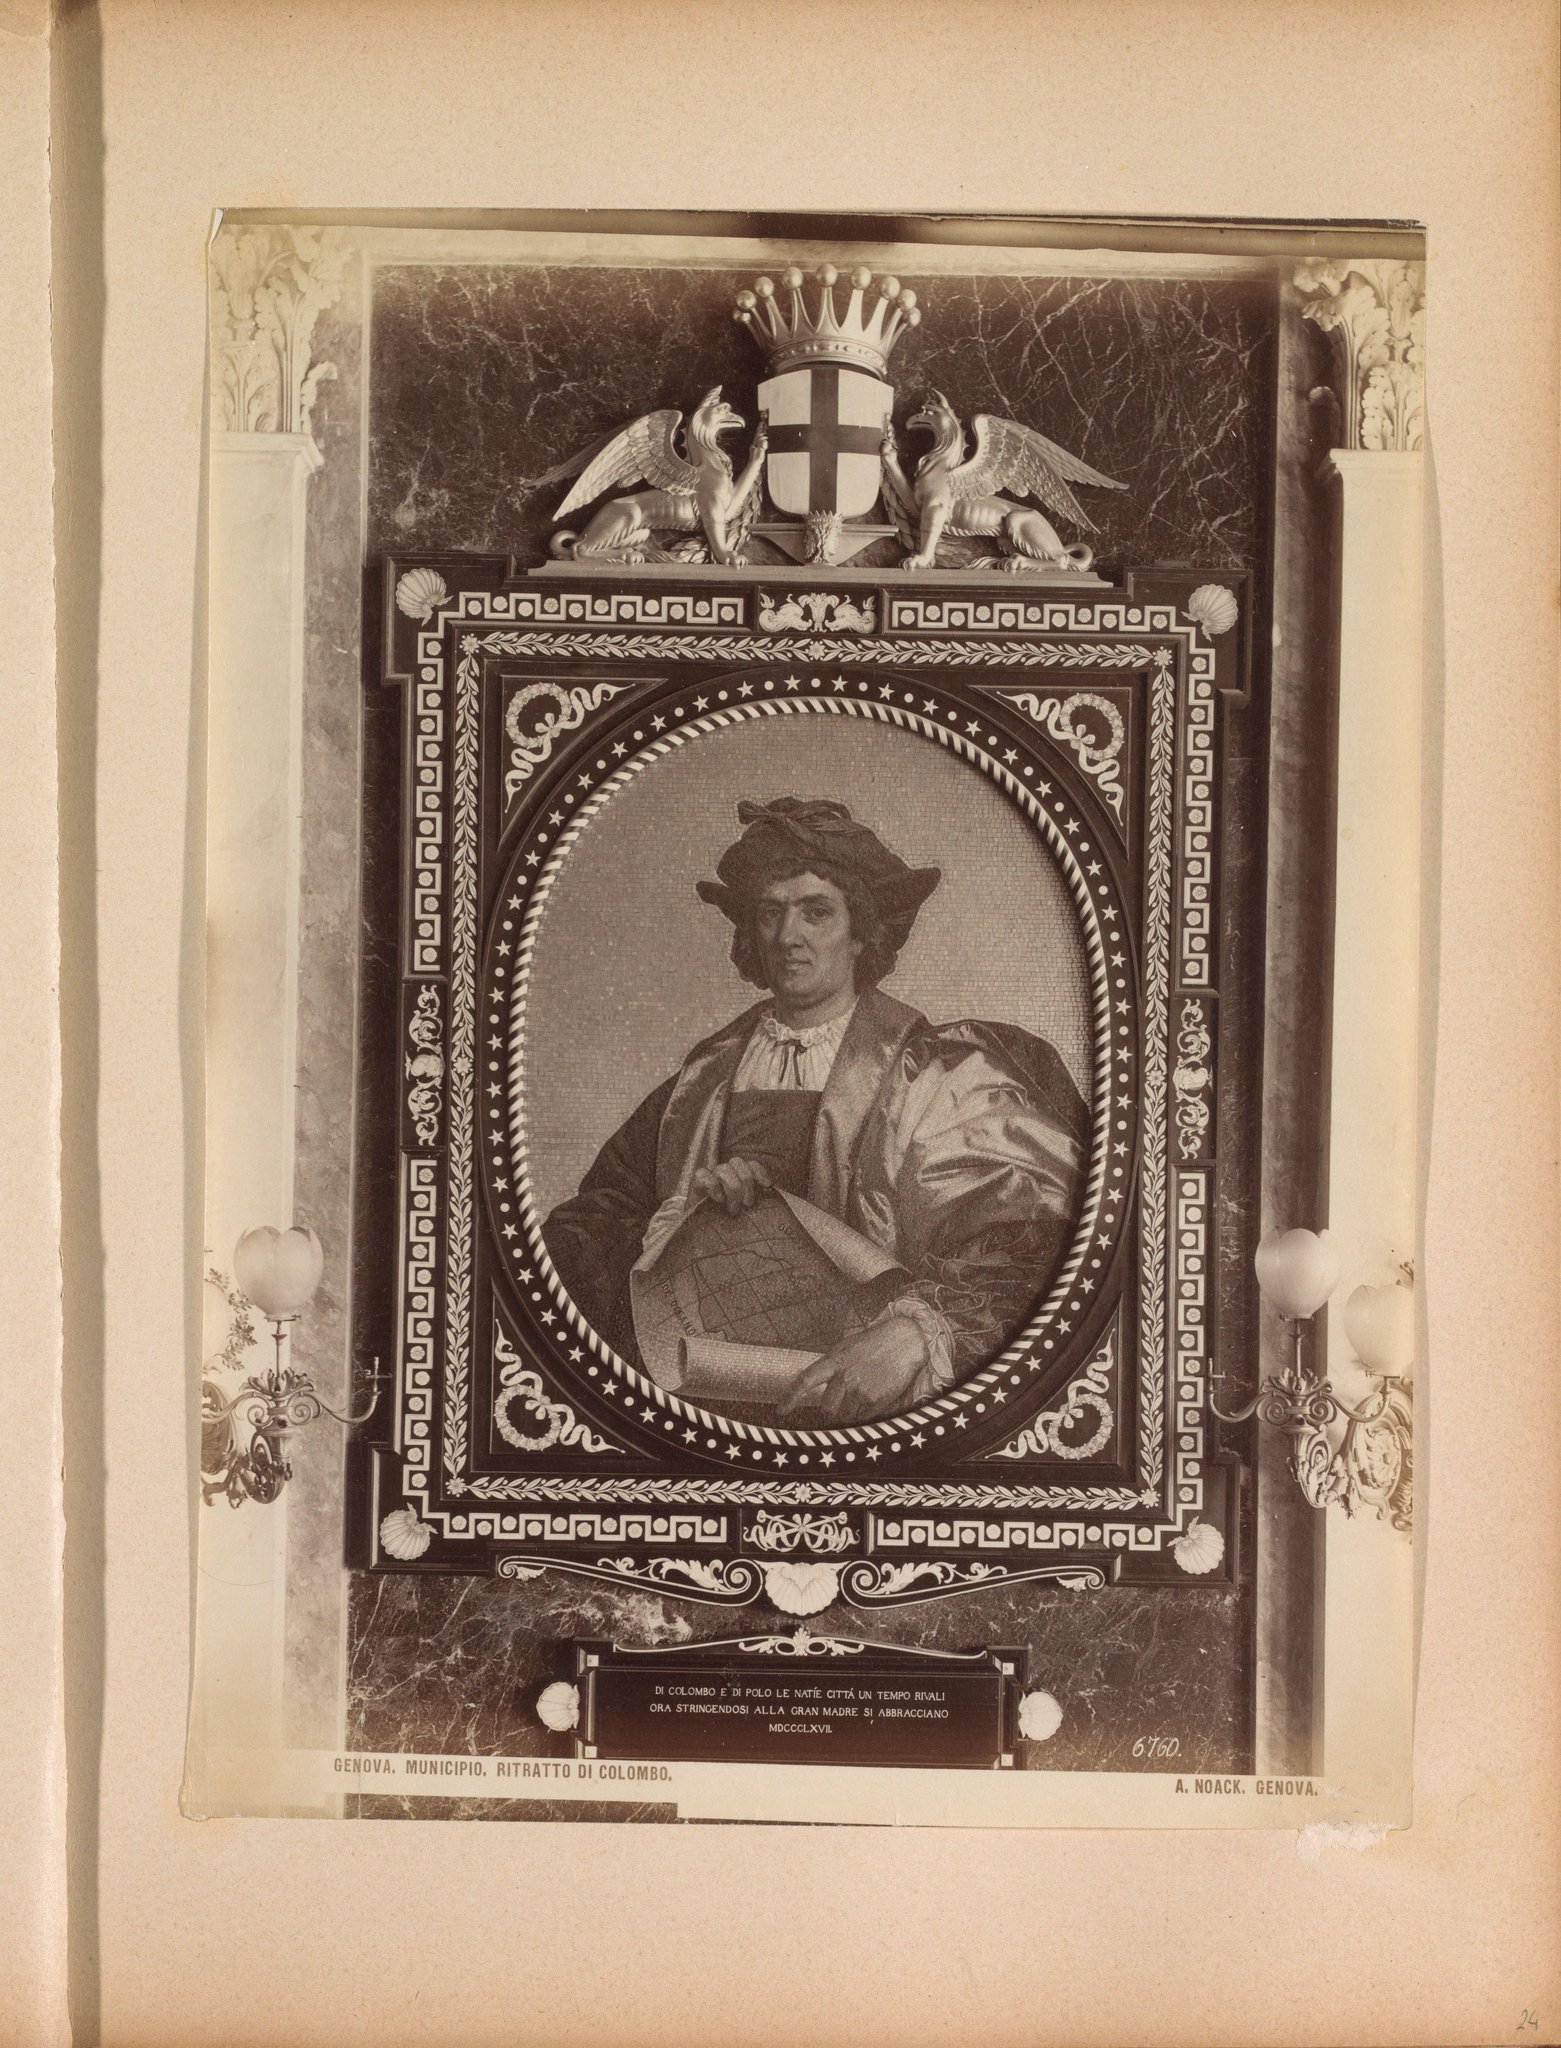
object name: photograph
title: Genova. Municipio. Ritratto di Colombo.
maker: alfredo noack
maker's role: fotograaf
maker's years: 1833-1895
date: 1870-1895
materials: paper, photographic support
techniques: albumen print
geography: genoa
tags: portrait, self-portrait of painter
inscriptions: negative number: ‘6760’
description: Onderdeel van Reisalbum met foto's van bezienswaardigheden in Italië en Zuid-Frankrijk.